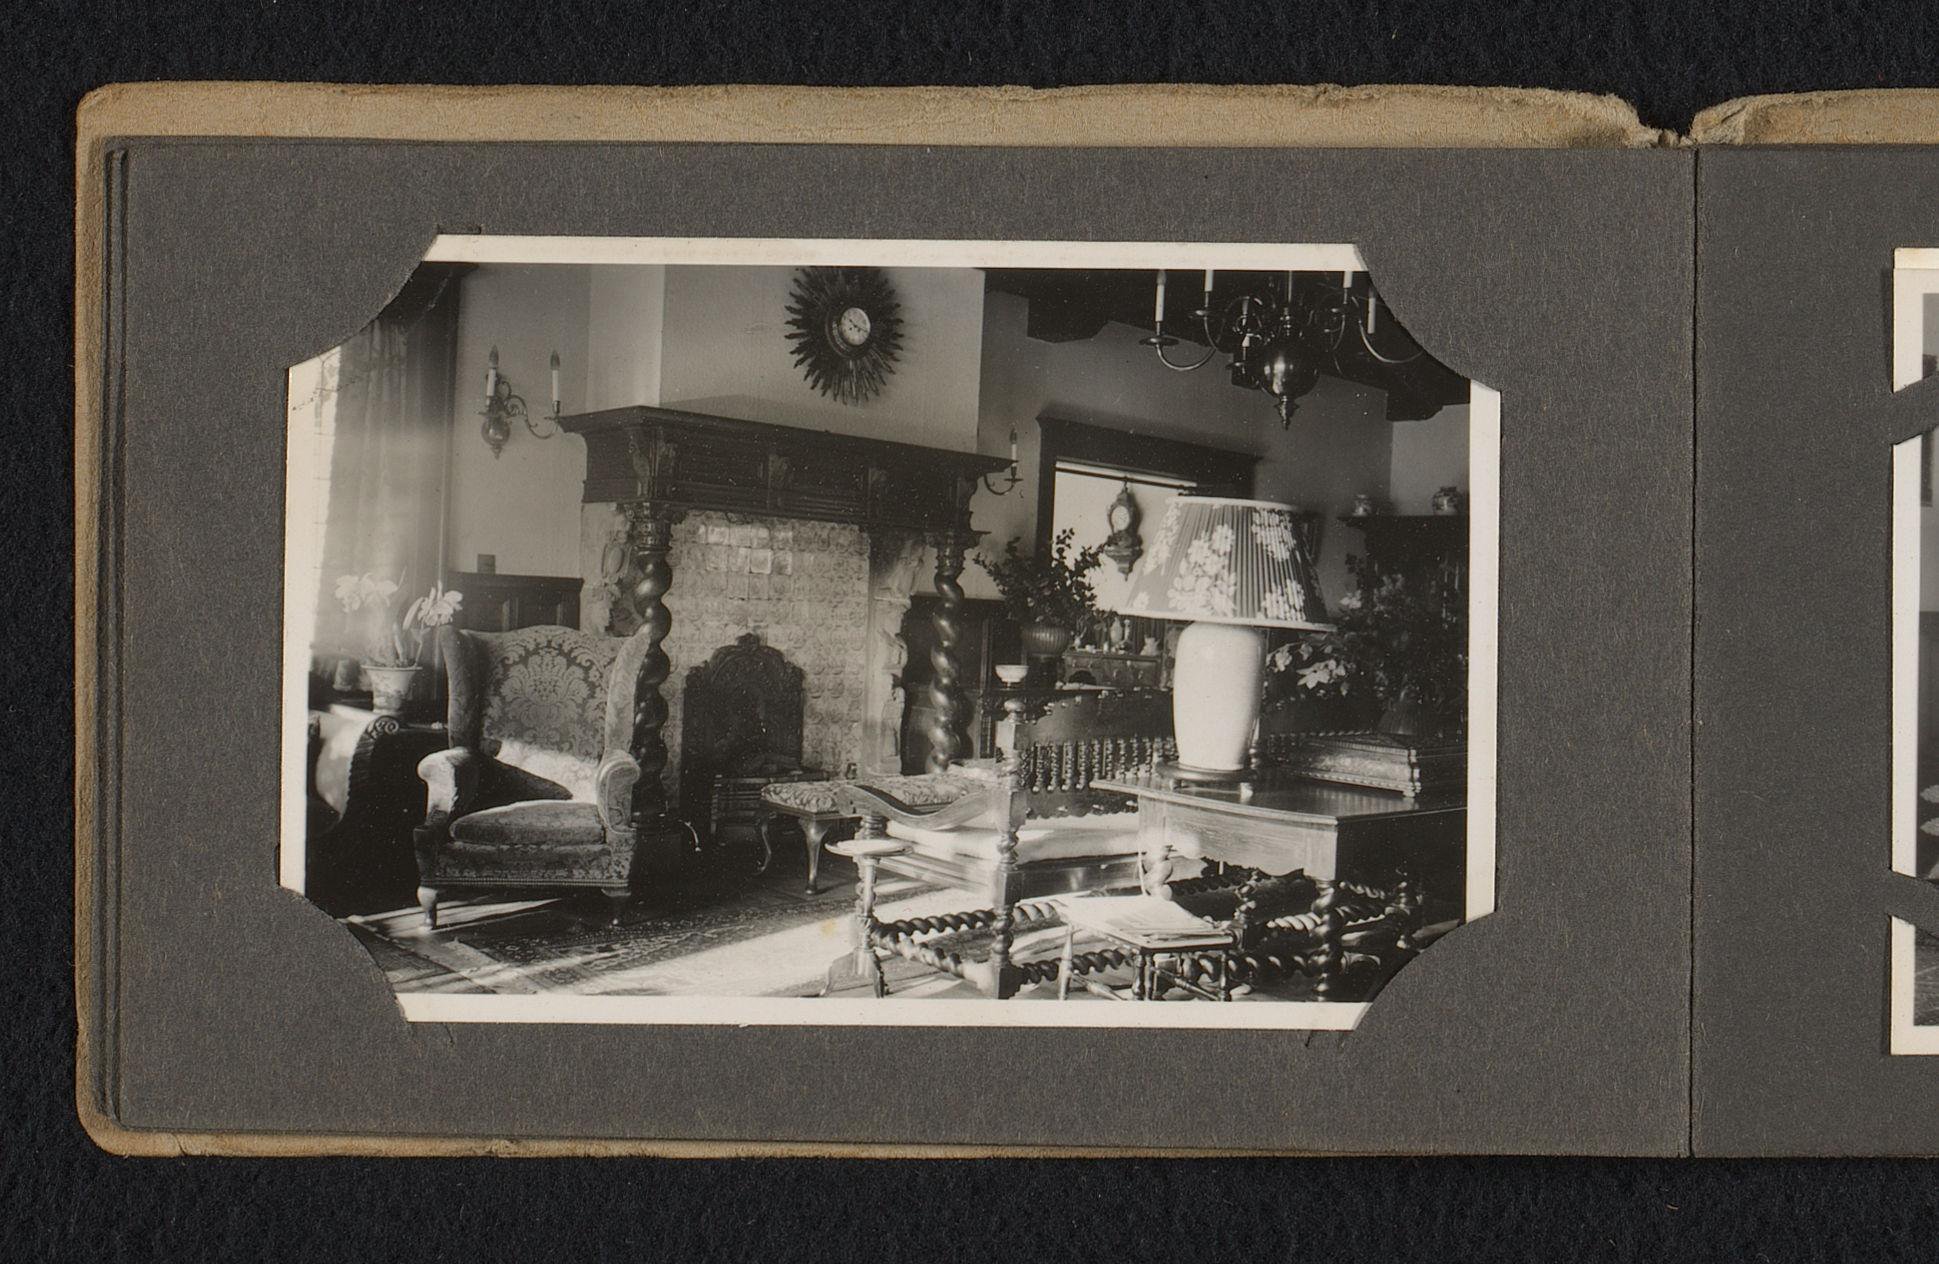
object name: album leaf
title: Interieur van het landhuis De Wilde Zwanen te Laren, met zicht op een schouw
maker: norbert van den berg (1901-1972)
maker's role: amateurfotograaf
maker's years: 1901-1972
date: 1940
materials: paper, cardboard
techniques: gelatin silver print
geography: laren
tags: interior of the house, chimney-piece, mantelpiece